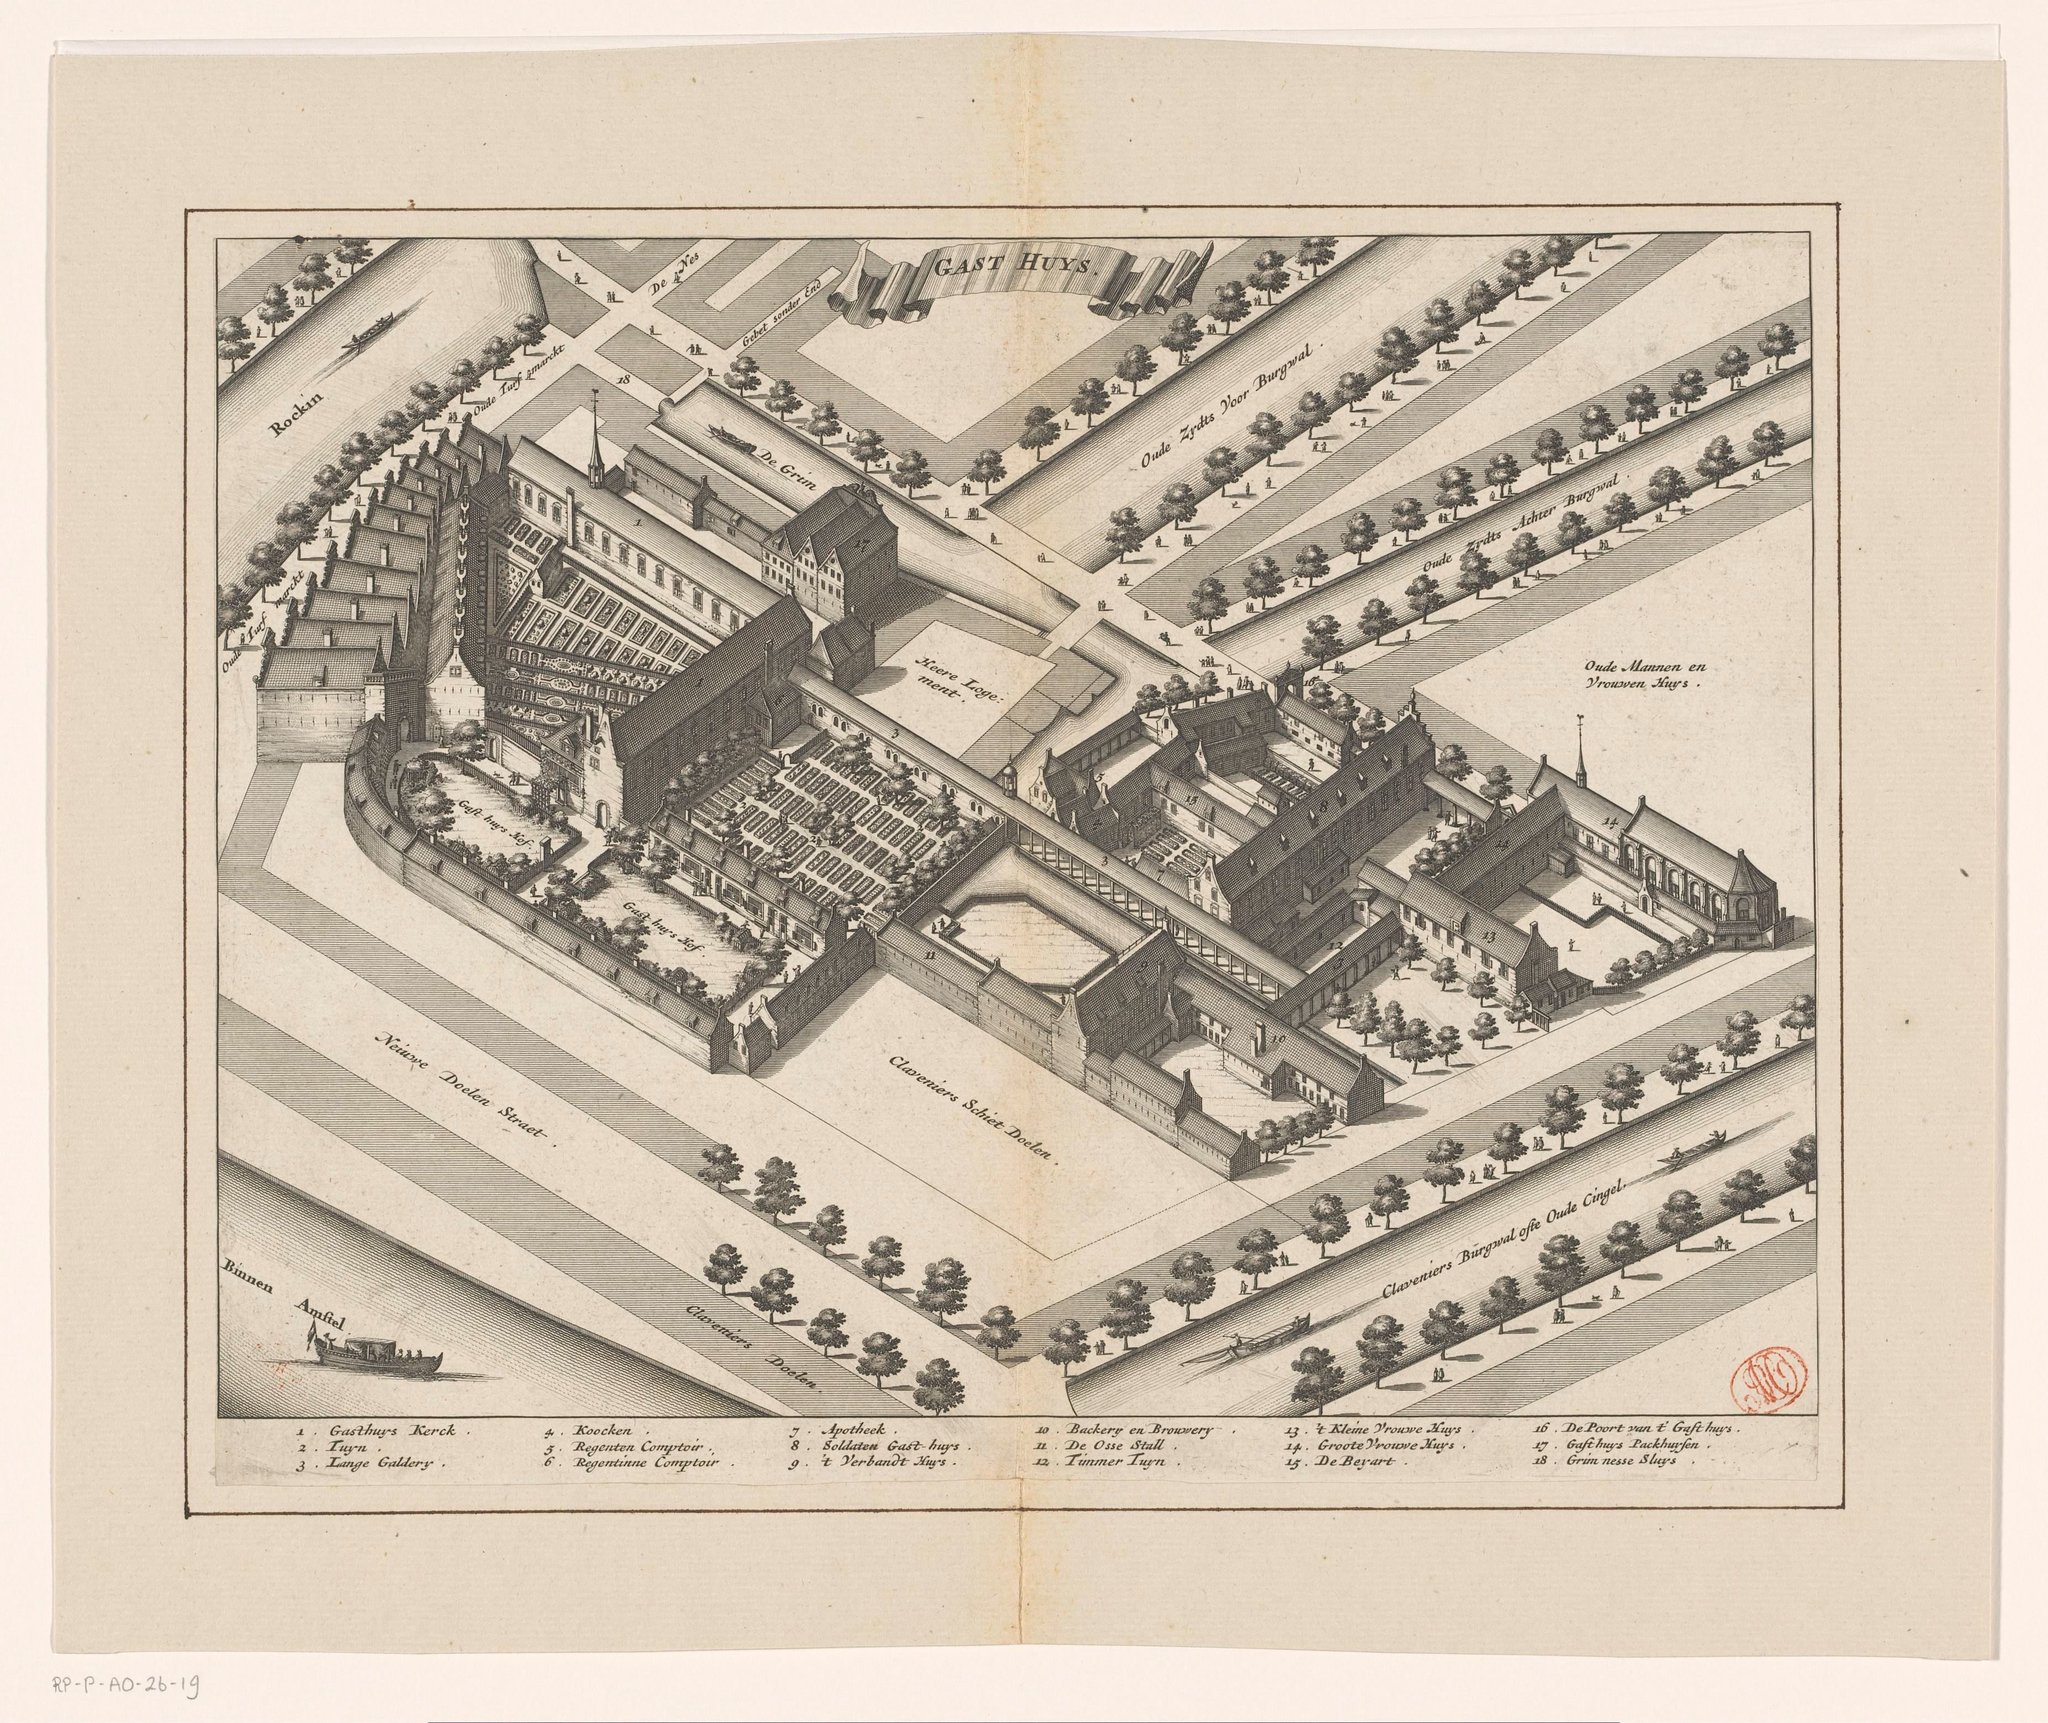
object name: print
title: Gast Huys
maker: Anonymous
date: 1693-1726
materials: paper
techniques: engraving, etching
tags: hospital, canals, waters (in city) (+ city(-scape) with figures, staffage)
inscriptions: collector's mark: Lugt 195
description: Prent ook gebruikt in: Commelin, Caspar. Beschryvinge van Amsterdam, desselfs eerste oorspronk uyt den Huyse (…). 2 delen. Amsterdam: Abraham Wolfgang, Gillis Janssonius van Waesberge, Johannes Janssonius van Waesberge II, weduwe Dirk Boom I, Hendrick Boom en Rembertus Goethals, 1693. En in: Commelin, Caspar. Beschryvinge van Amsterdam, zynde een naukeurige verhandelinge van desselfs eerste oorspronk uyt (…). 2 delen. Amsterdam: weduwe Aart Dircksz Oossaan, 1694. En in: Commelin, Caspar. Beschryvinge van Amsterdam, zynde een naukeurige verhandelinge van desselfs eerste oorspronk uyt (…). 2 delen. 2e druk. Amsterdam: Andries van Damme, Johannes Ratelband, weduwe A. van Aaltwyk en Hermanus Uytwerf, 1726.